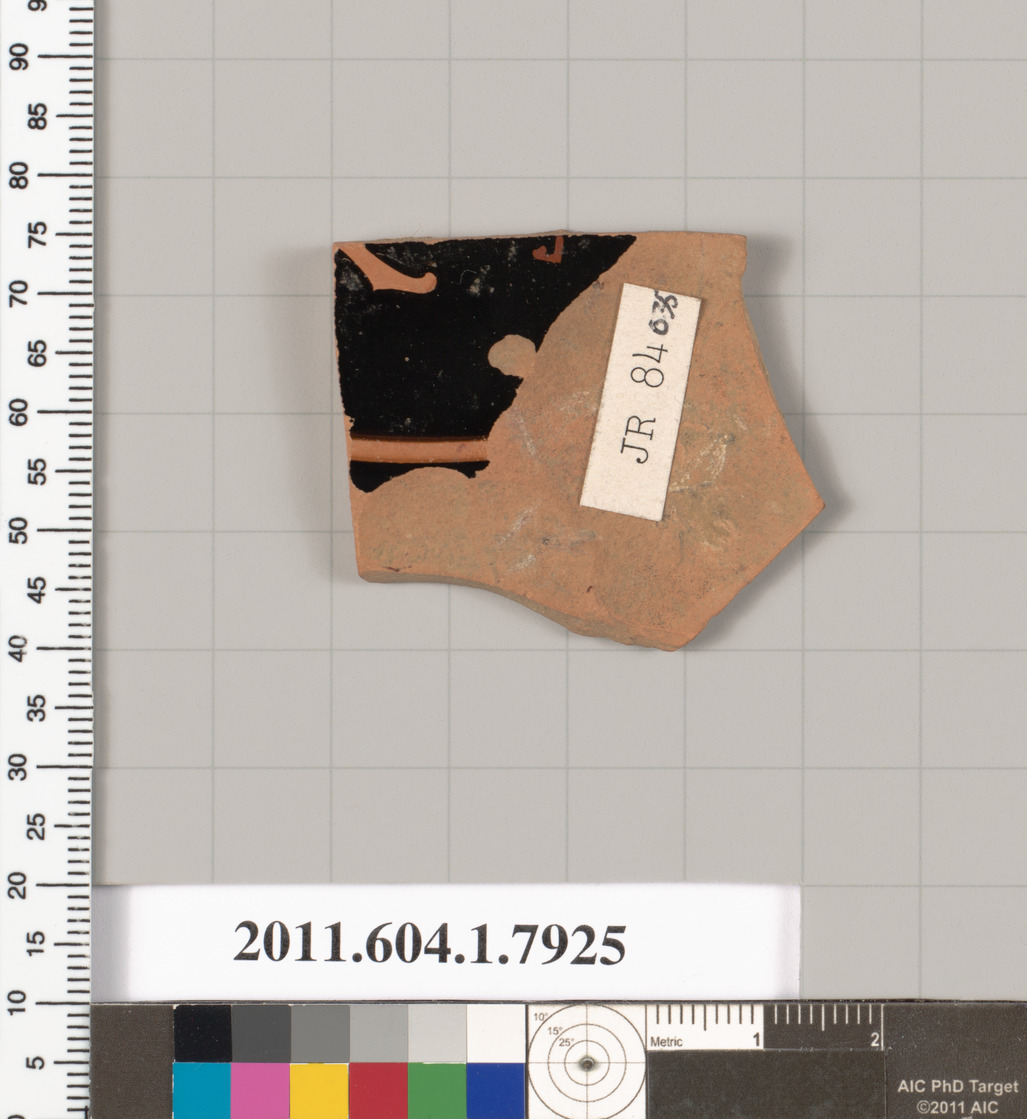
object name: kylix fragment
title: Terracotta fragment of a kylix (drinking cup)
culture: greek, attic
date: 460-450 BCE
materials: terracotta